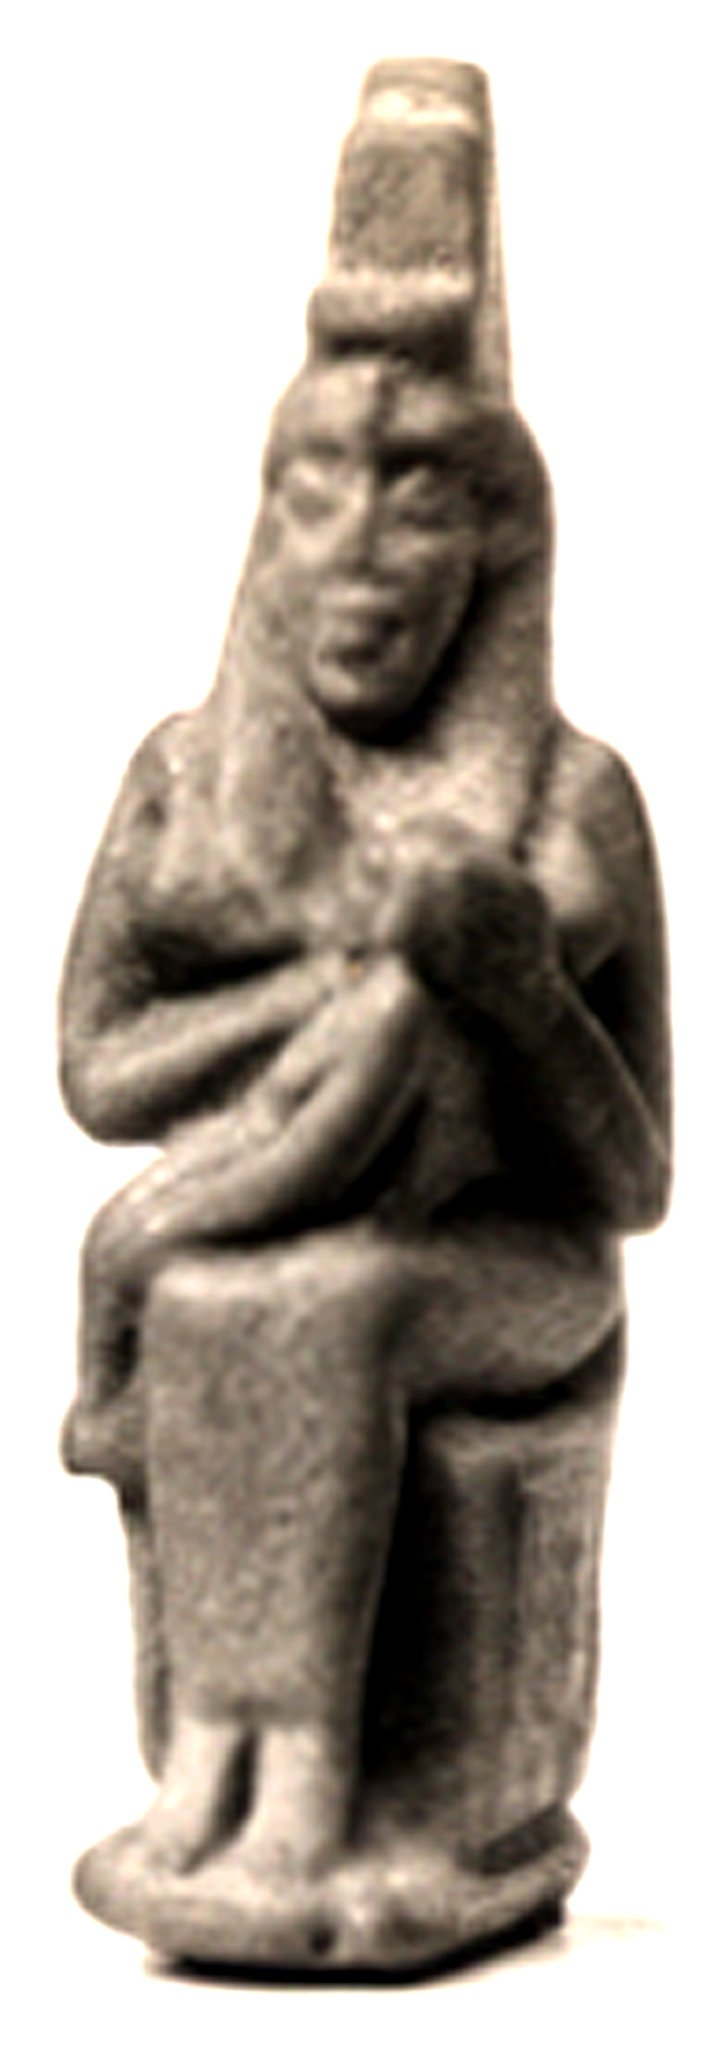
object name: amulet, isi, horus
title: Amulet, Isis, Horus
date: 522-343 BCE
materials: faience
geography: egypt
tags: horus,isis